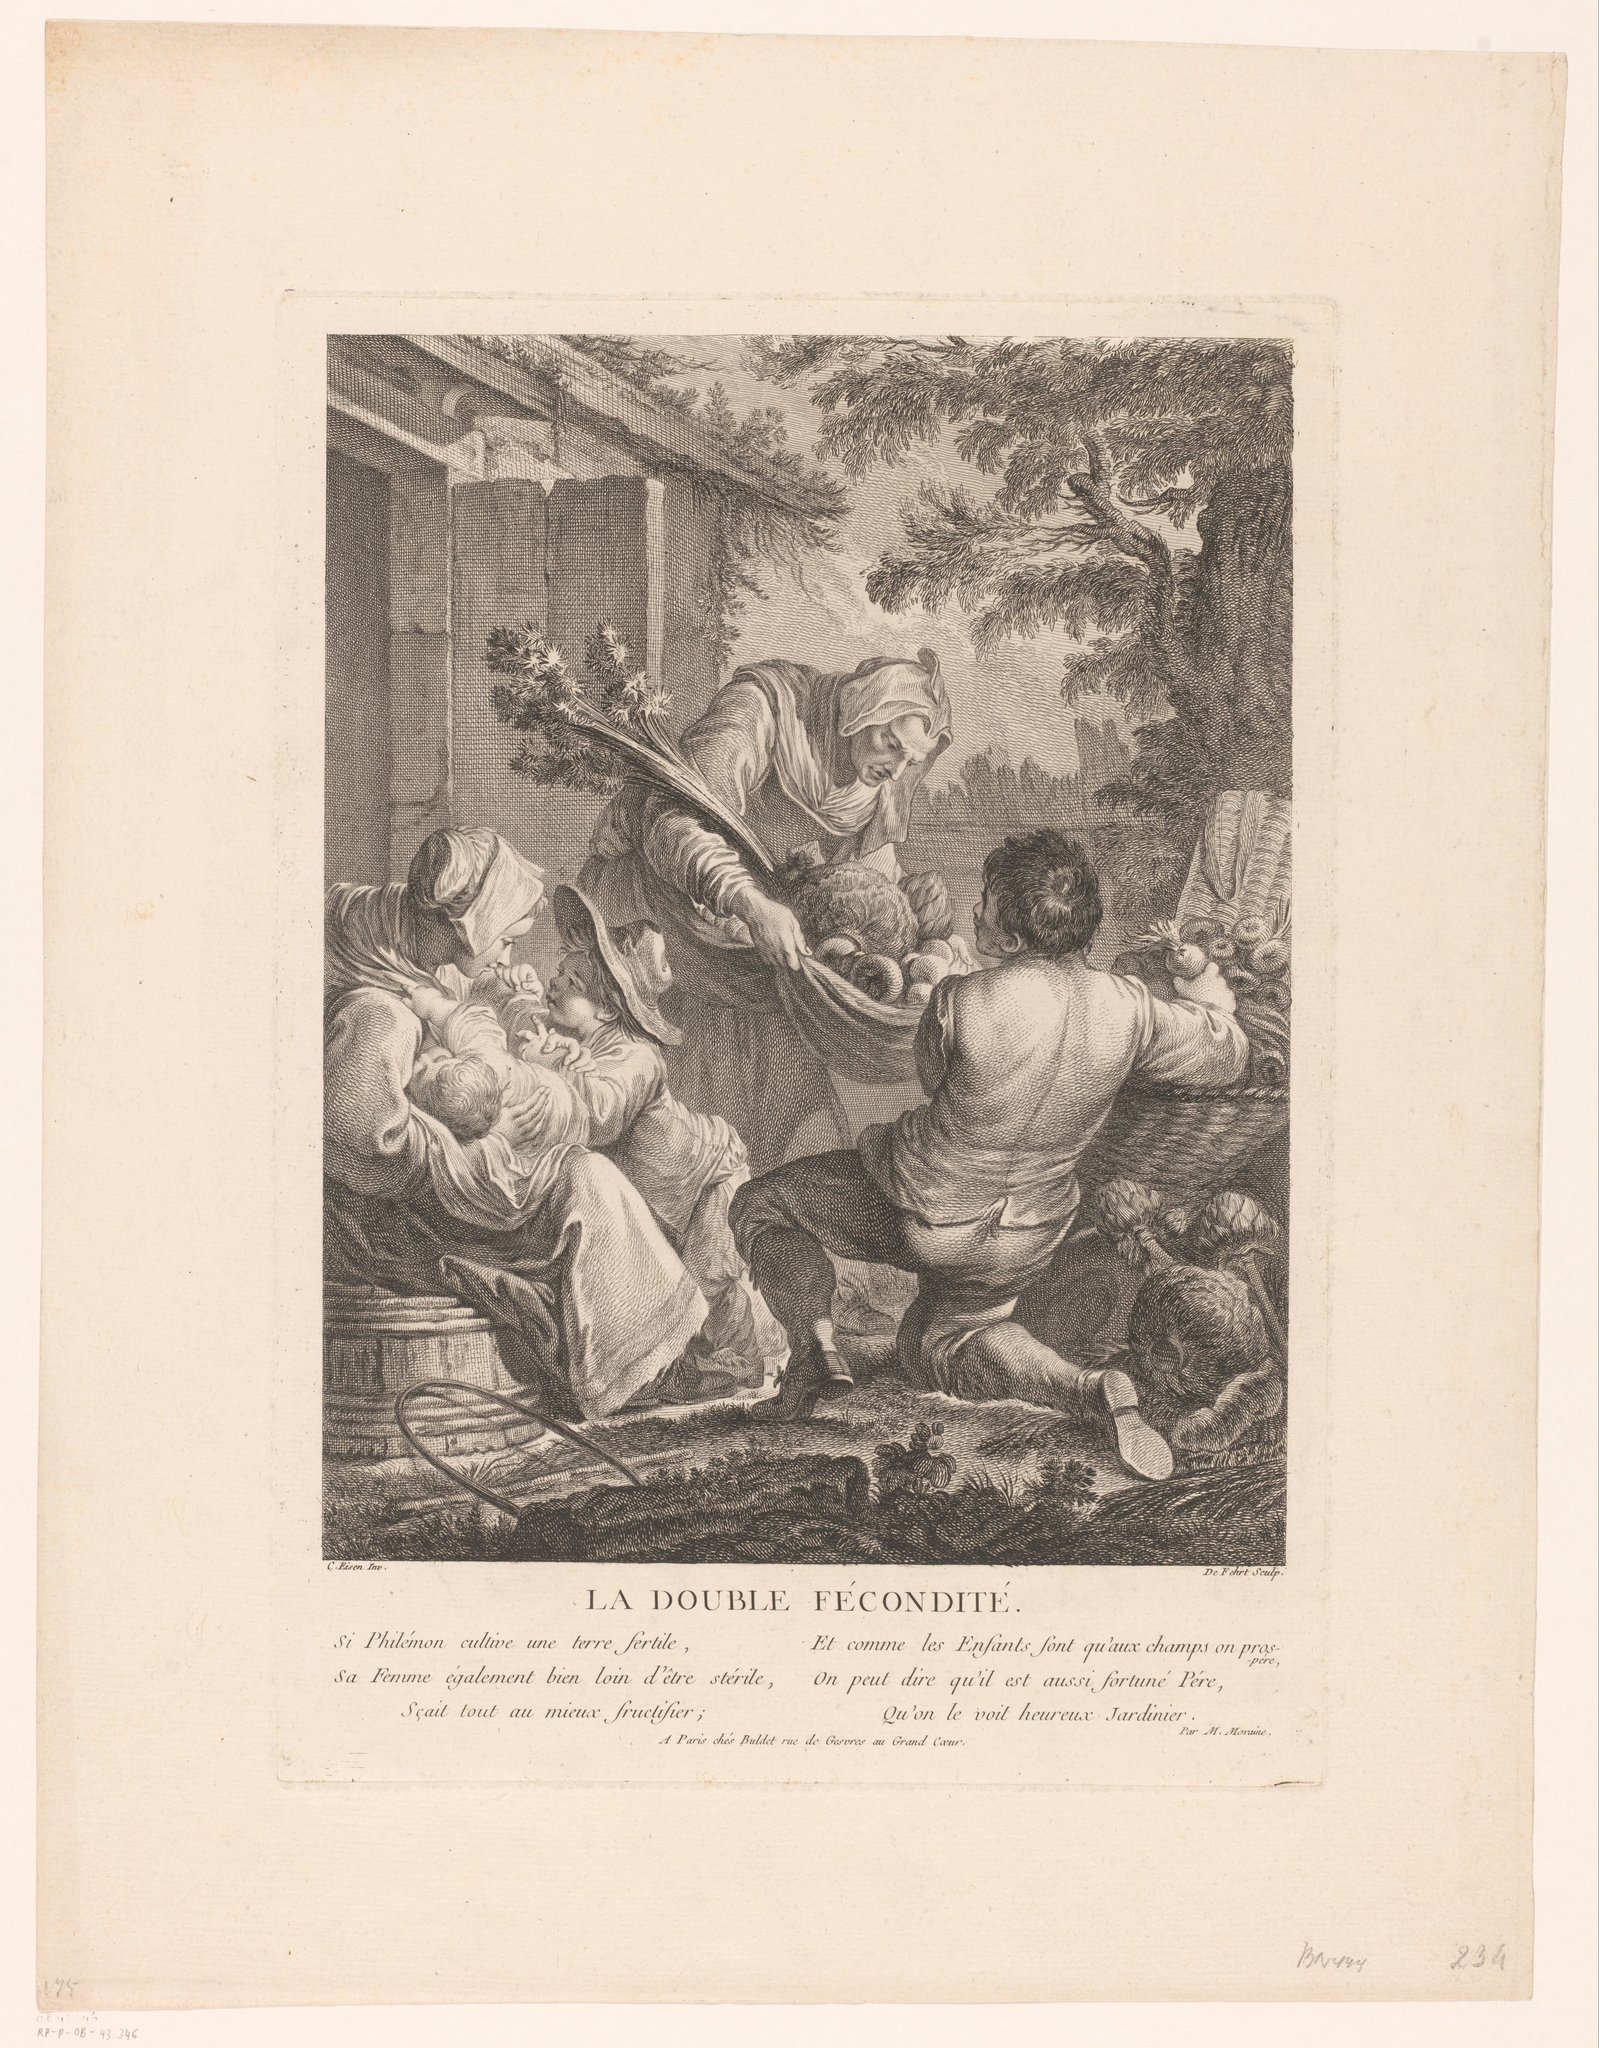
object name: print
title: Personificatie van de vruchtbaarheid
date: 1759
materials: paper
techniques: engraving, etching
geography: france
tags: vegetables, fertility, mother and child(ren), woman and child(ren) (family group)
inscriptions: collector's mark: Lugt 2228